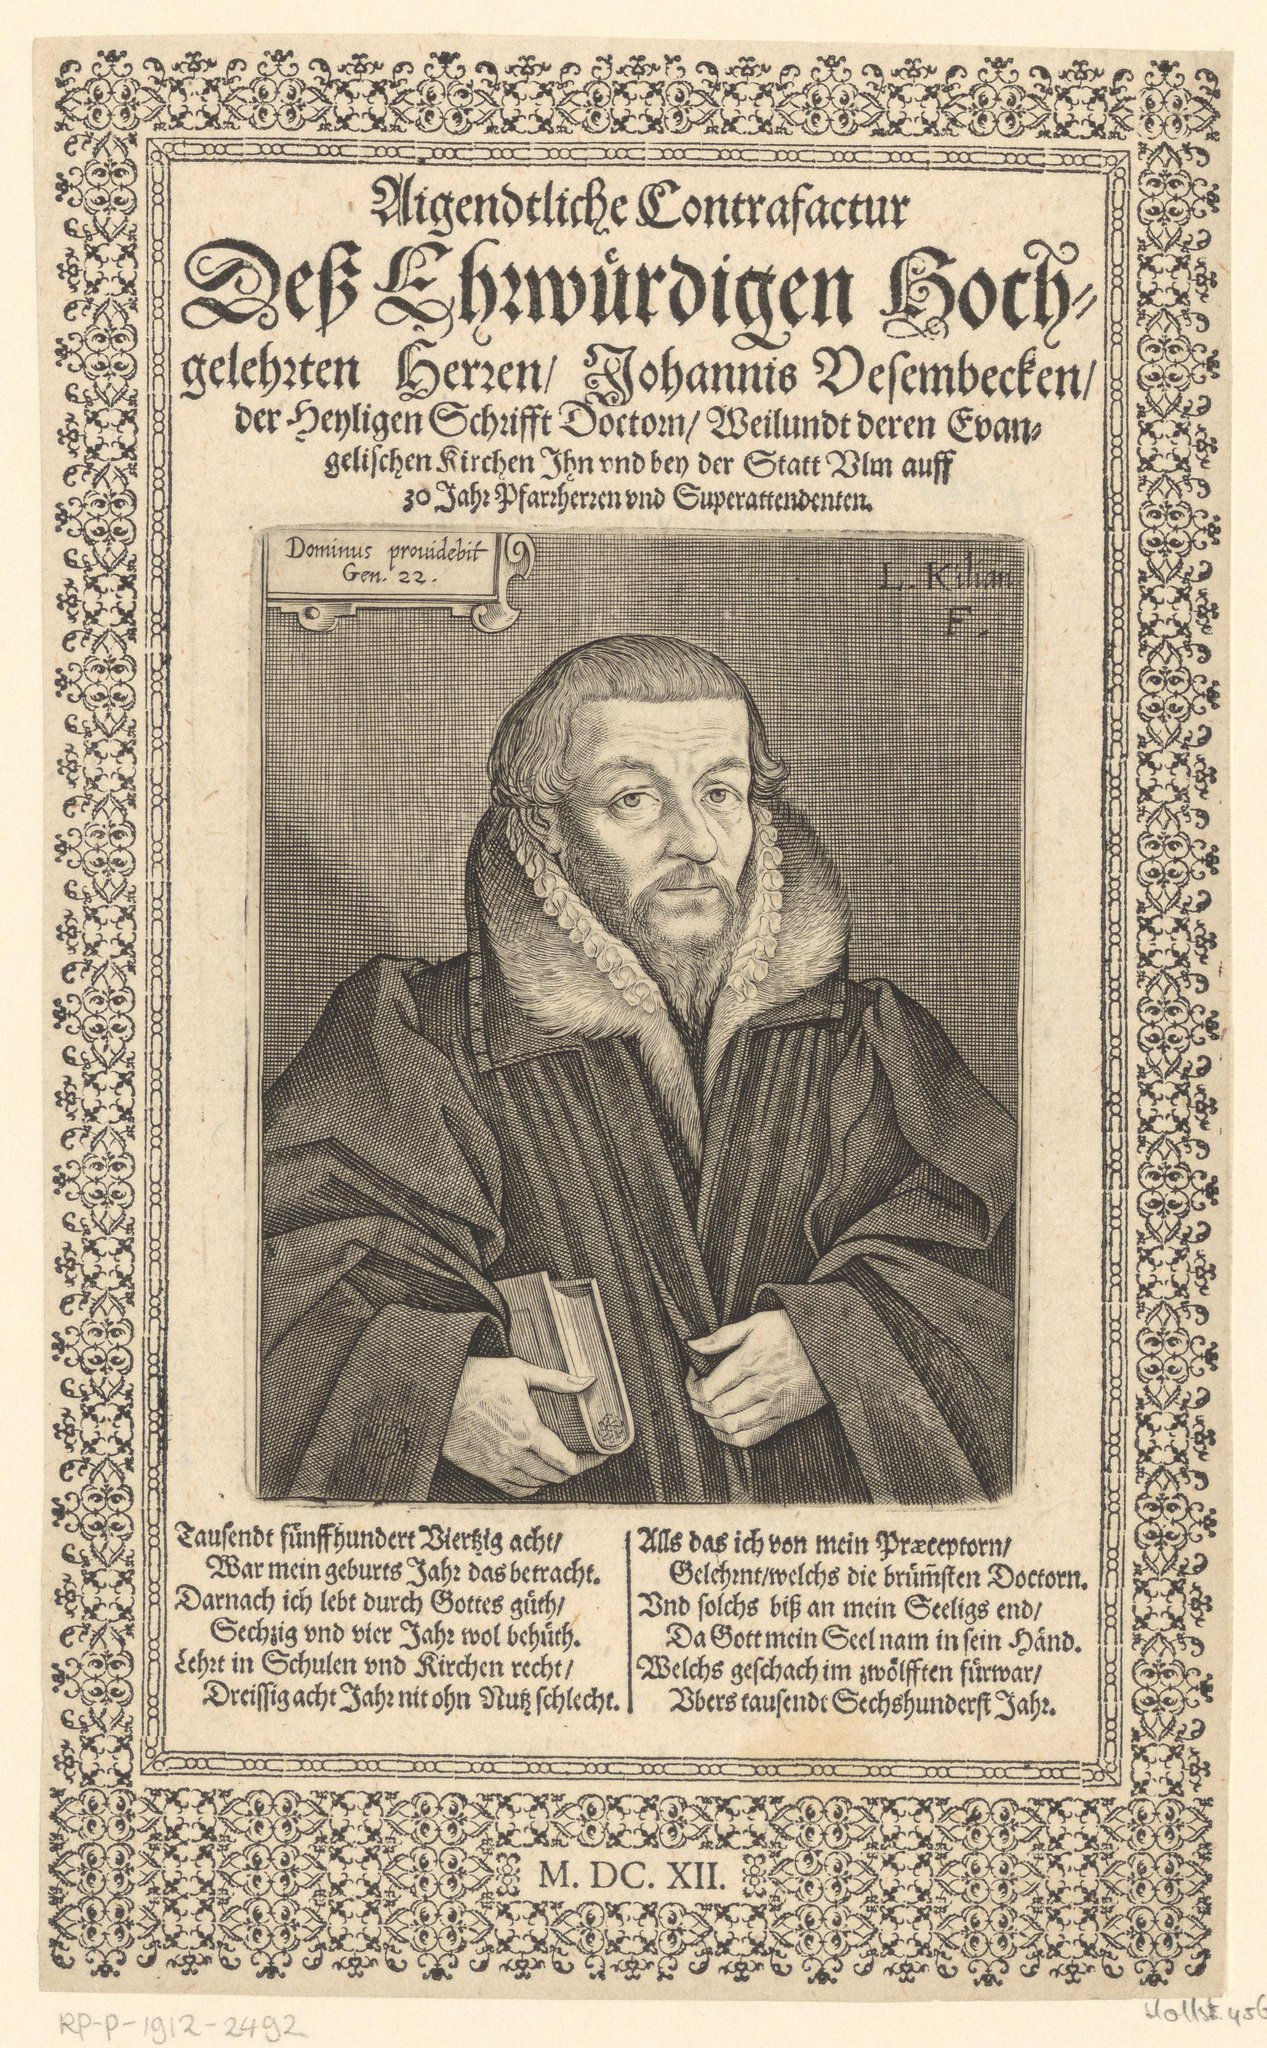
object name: print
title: Portret van Johann Wesenbeck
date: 1612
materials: paper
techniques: engraving, letterpress printing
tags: theologian, historical persons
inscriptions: collector's mark: Lugt 2228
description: Tekst in het Latijn in het kader. Tekst in het Duits in boekdruk binnen een omkadering van fleurons op het blad.